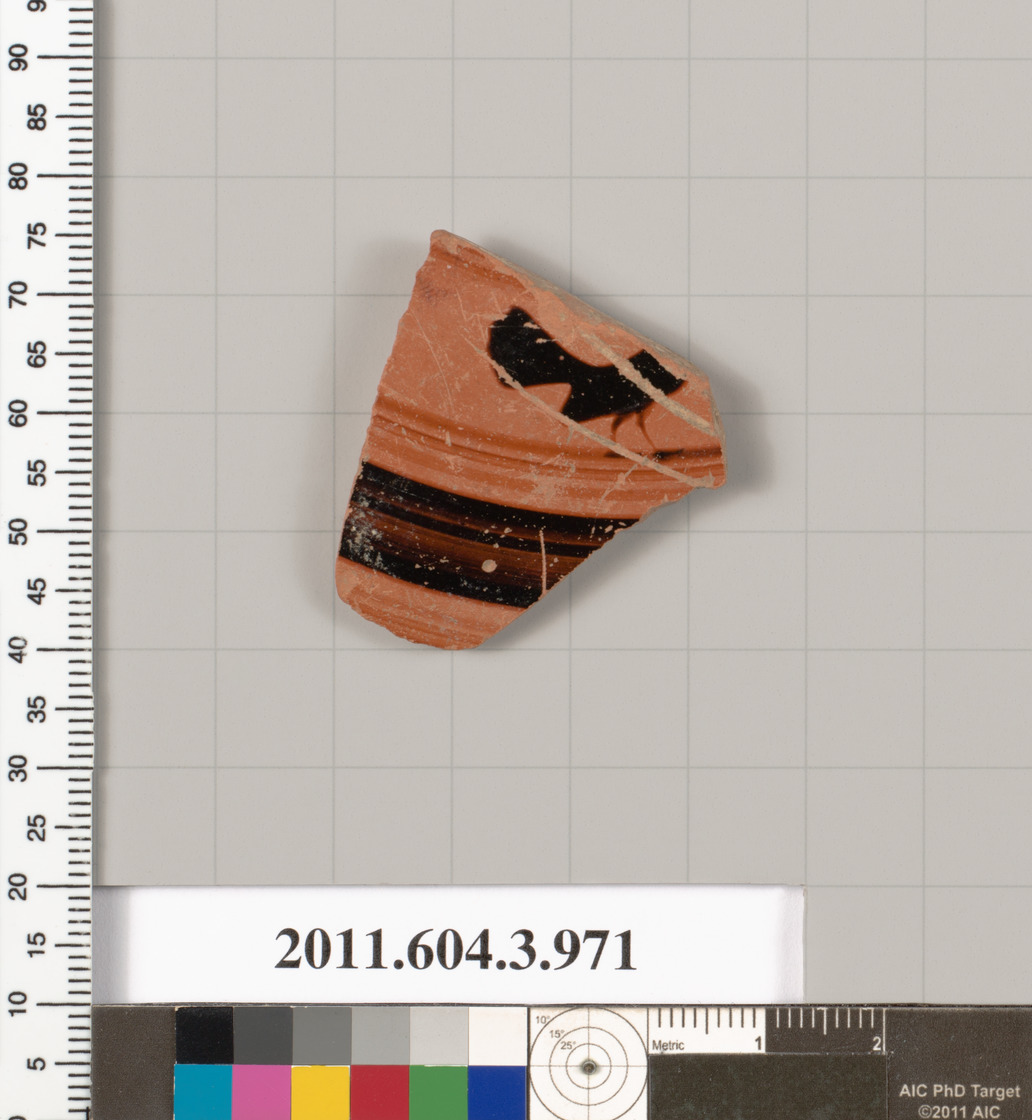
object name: lekanis lid fragment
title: Terracotta fragment of a lekanis lid (covered dish)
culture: greek, attic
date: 575-551 BCE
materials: terracotta